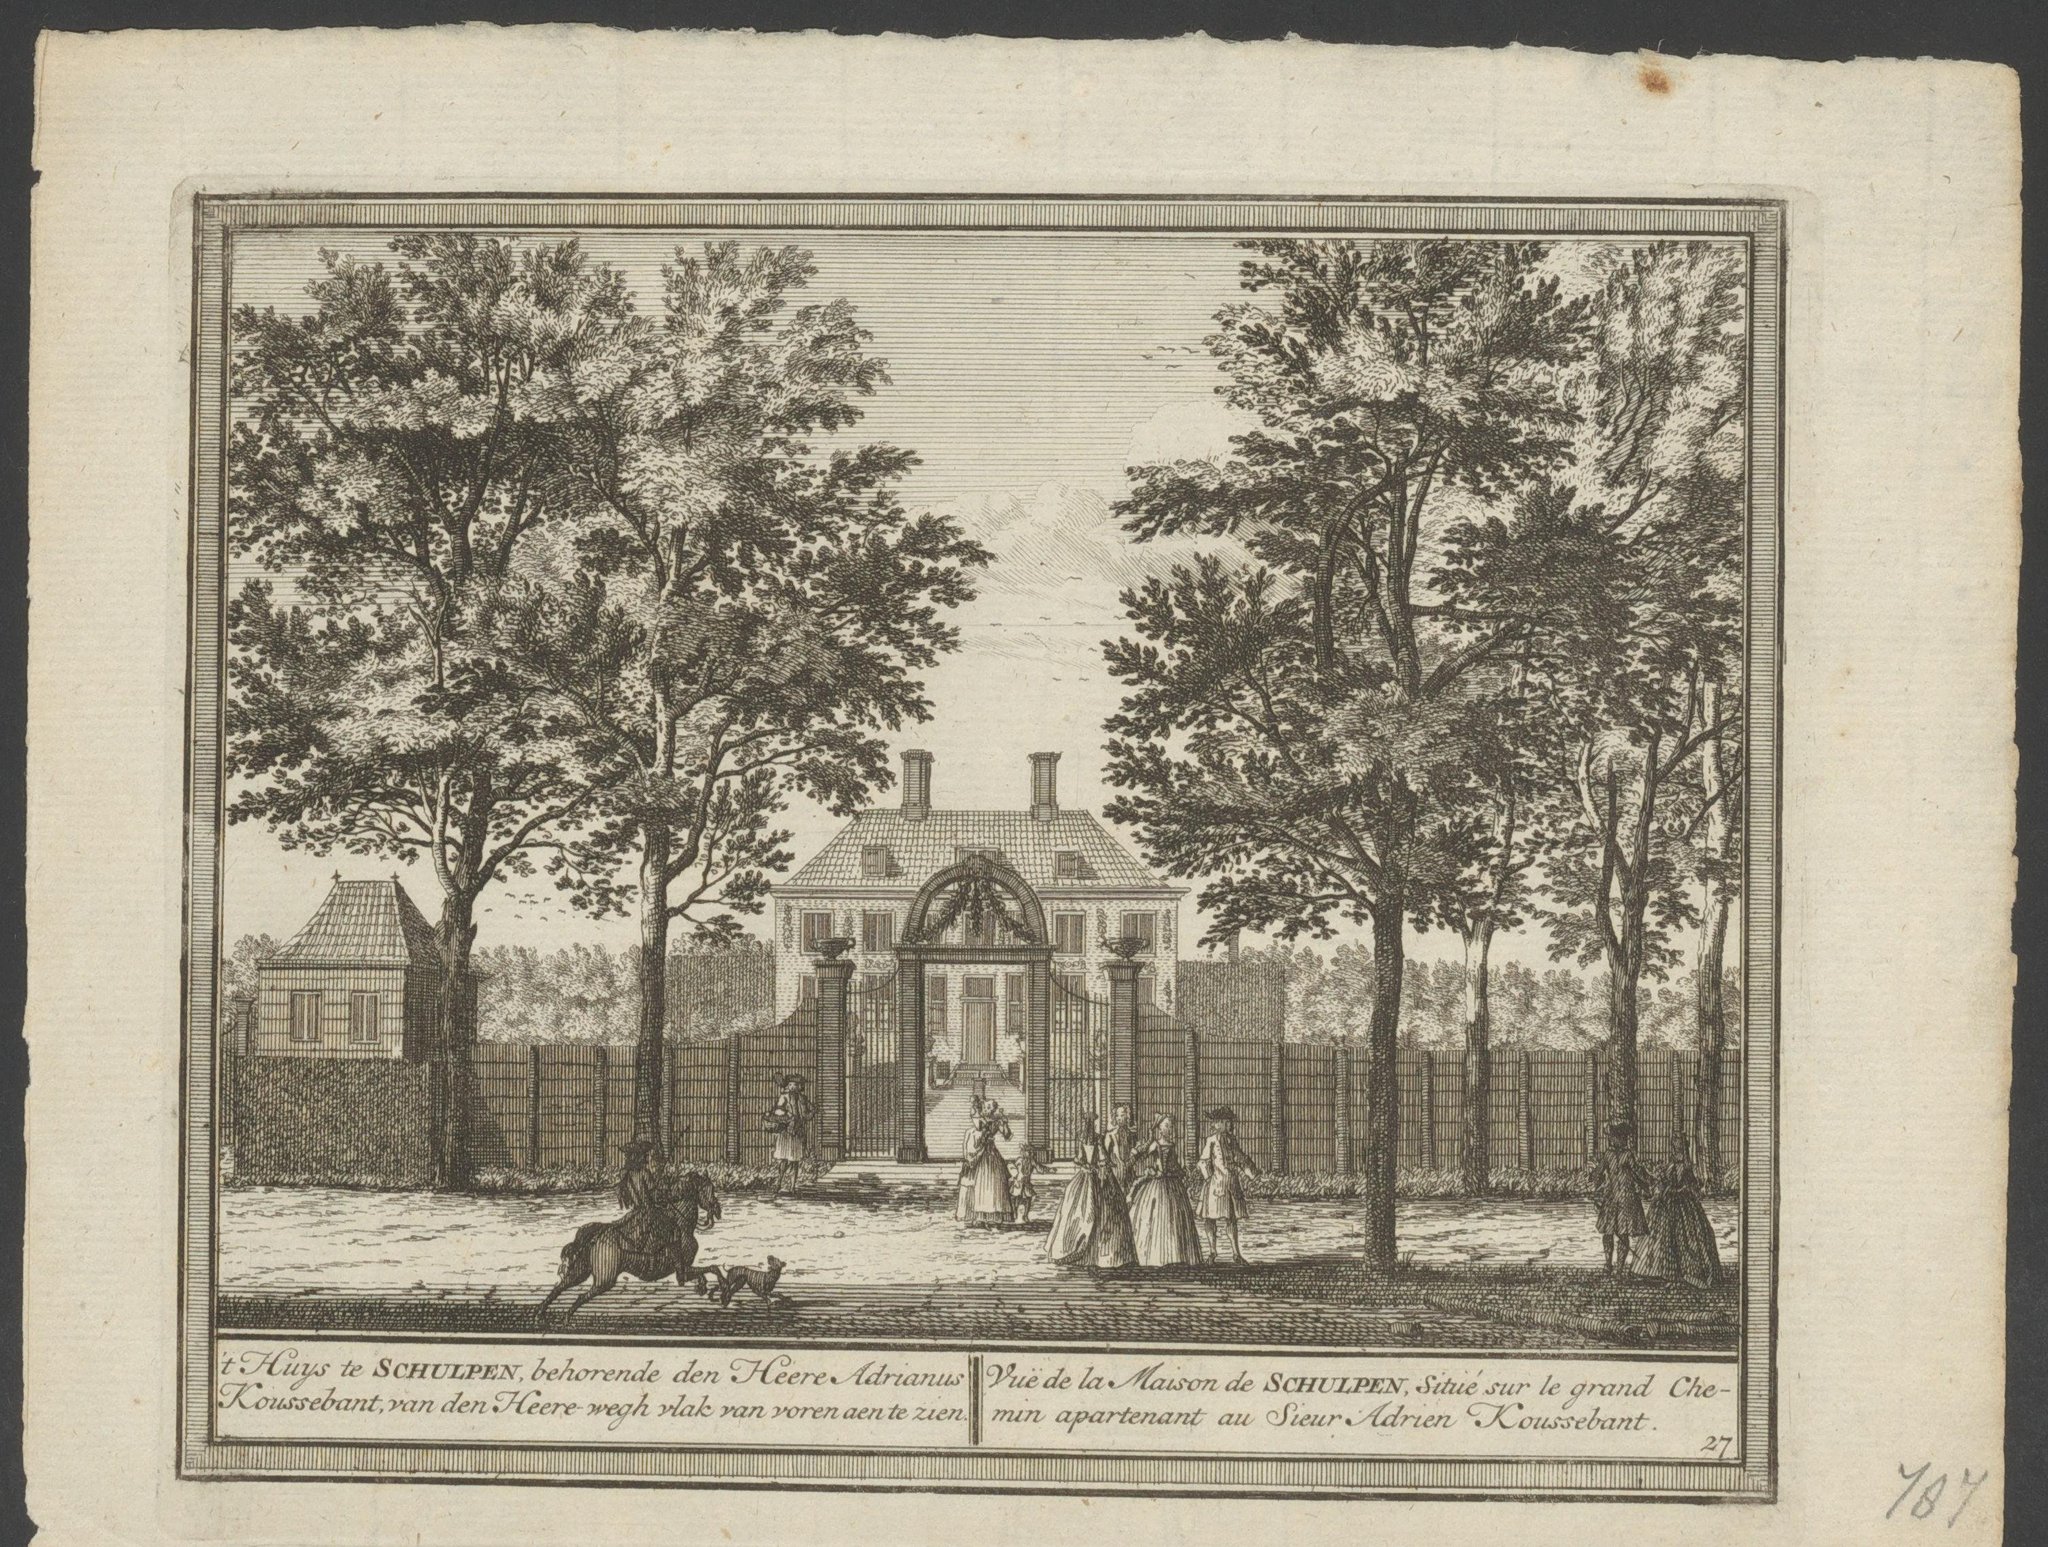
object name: print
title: 't Huys te Schulpen, behorende den Heere Adrianus Koussebant (...) / Vuë de la Maison de Schulpen, Situé sur le grand Chemin (...)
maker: hendrik de leth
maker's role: draughtsman, print maker, publisher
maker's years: 1703-1766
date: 1729-1732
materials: paper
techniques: engraving, etching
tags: rural housing, e.g. country-house, villa, cottage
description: Prent mogelijk uit: Nidek, Matthaeus Brouërius. Het zegenpralent Kennemerlant, vertoont in veele heerelyke gezichten van deszelfs voornaemste lustplaetzen, adelyke huizen, dorp- en stede-gebouwen (...). Amsterdam: Andries en Hendrik de Leth, 1729-1732.